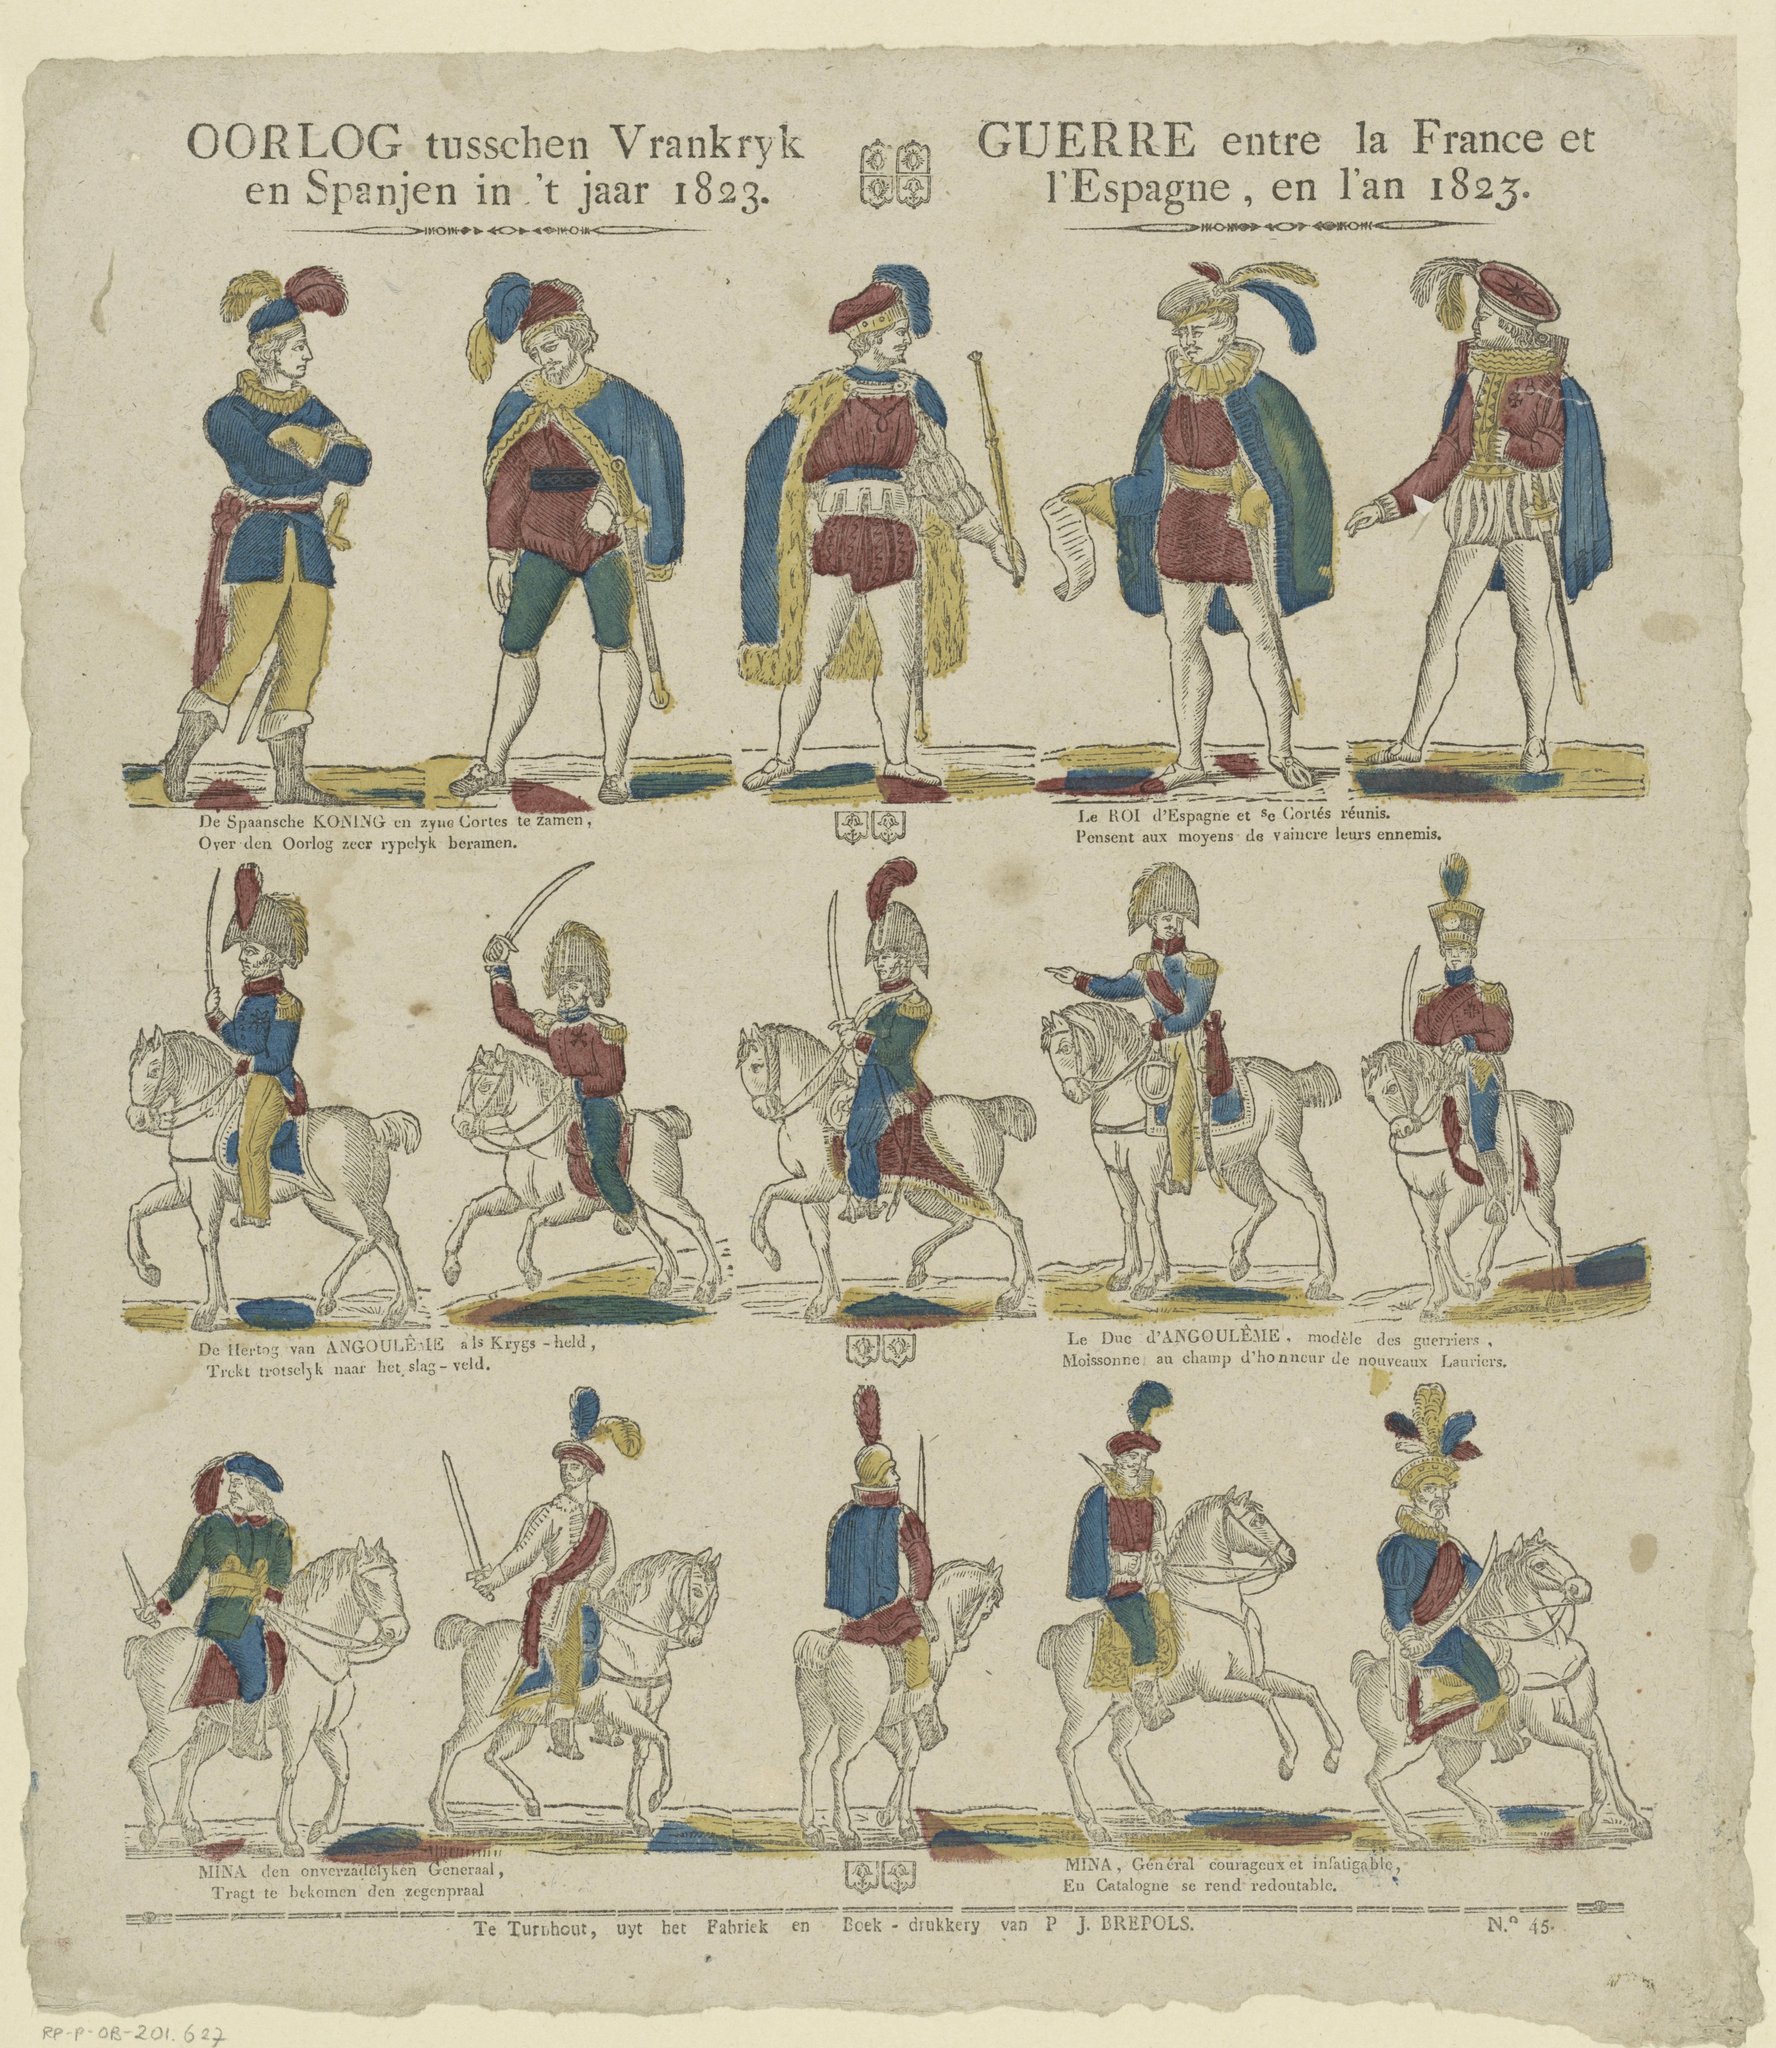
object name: popular print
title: Oorlog tusschen Vrankryk / en Spanjen in 't jaar 1823 / Guerre entre la France et / l'Espagne, en l'an 1823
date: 1800-1833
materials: paper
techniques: colour, letterpress printing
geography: turnhout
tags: warfare; military affairs (+ cavalry, horsemen)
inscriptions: collector's mark: Lugt 2760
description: Blad met 3 horizontale rijen met voorstellingen van figuren uit de oorlog tussen Spanje en Frankrijk in 1823. Boven: de Spaanse koning met zijn generaals. Midden: de Hertog van Angoulême met zijn soldaten te paard. Onder: generaal Midas met zijn soldaten te paard. Onder elke voorstelling een tweeregelig vers in het Nederlands en in het Frans. Genummerd rechtsonder: No. 45.